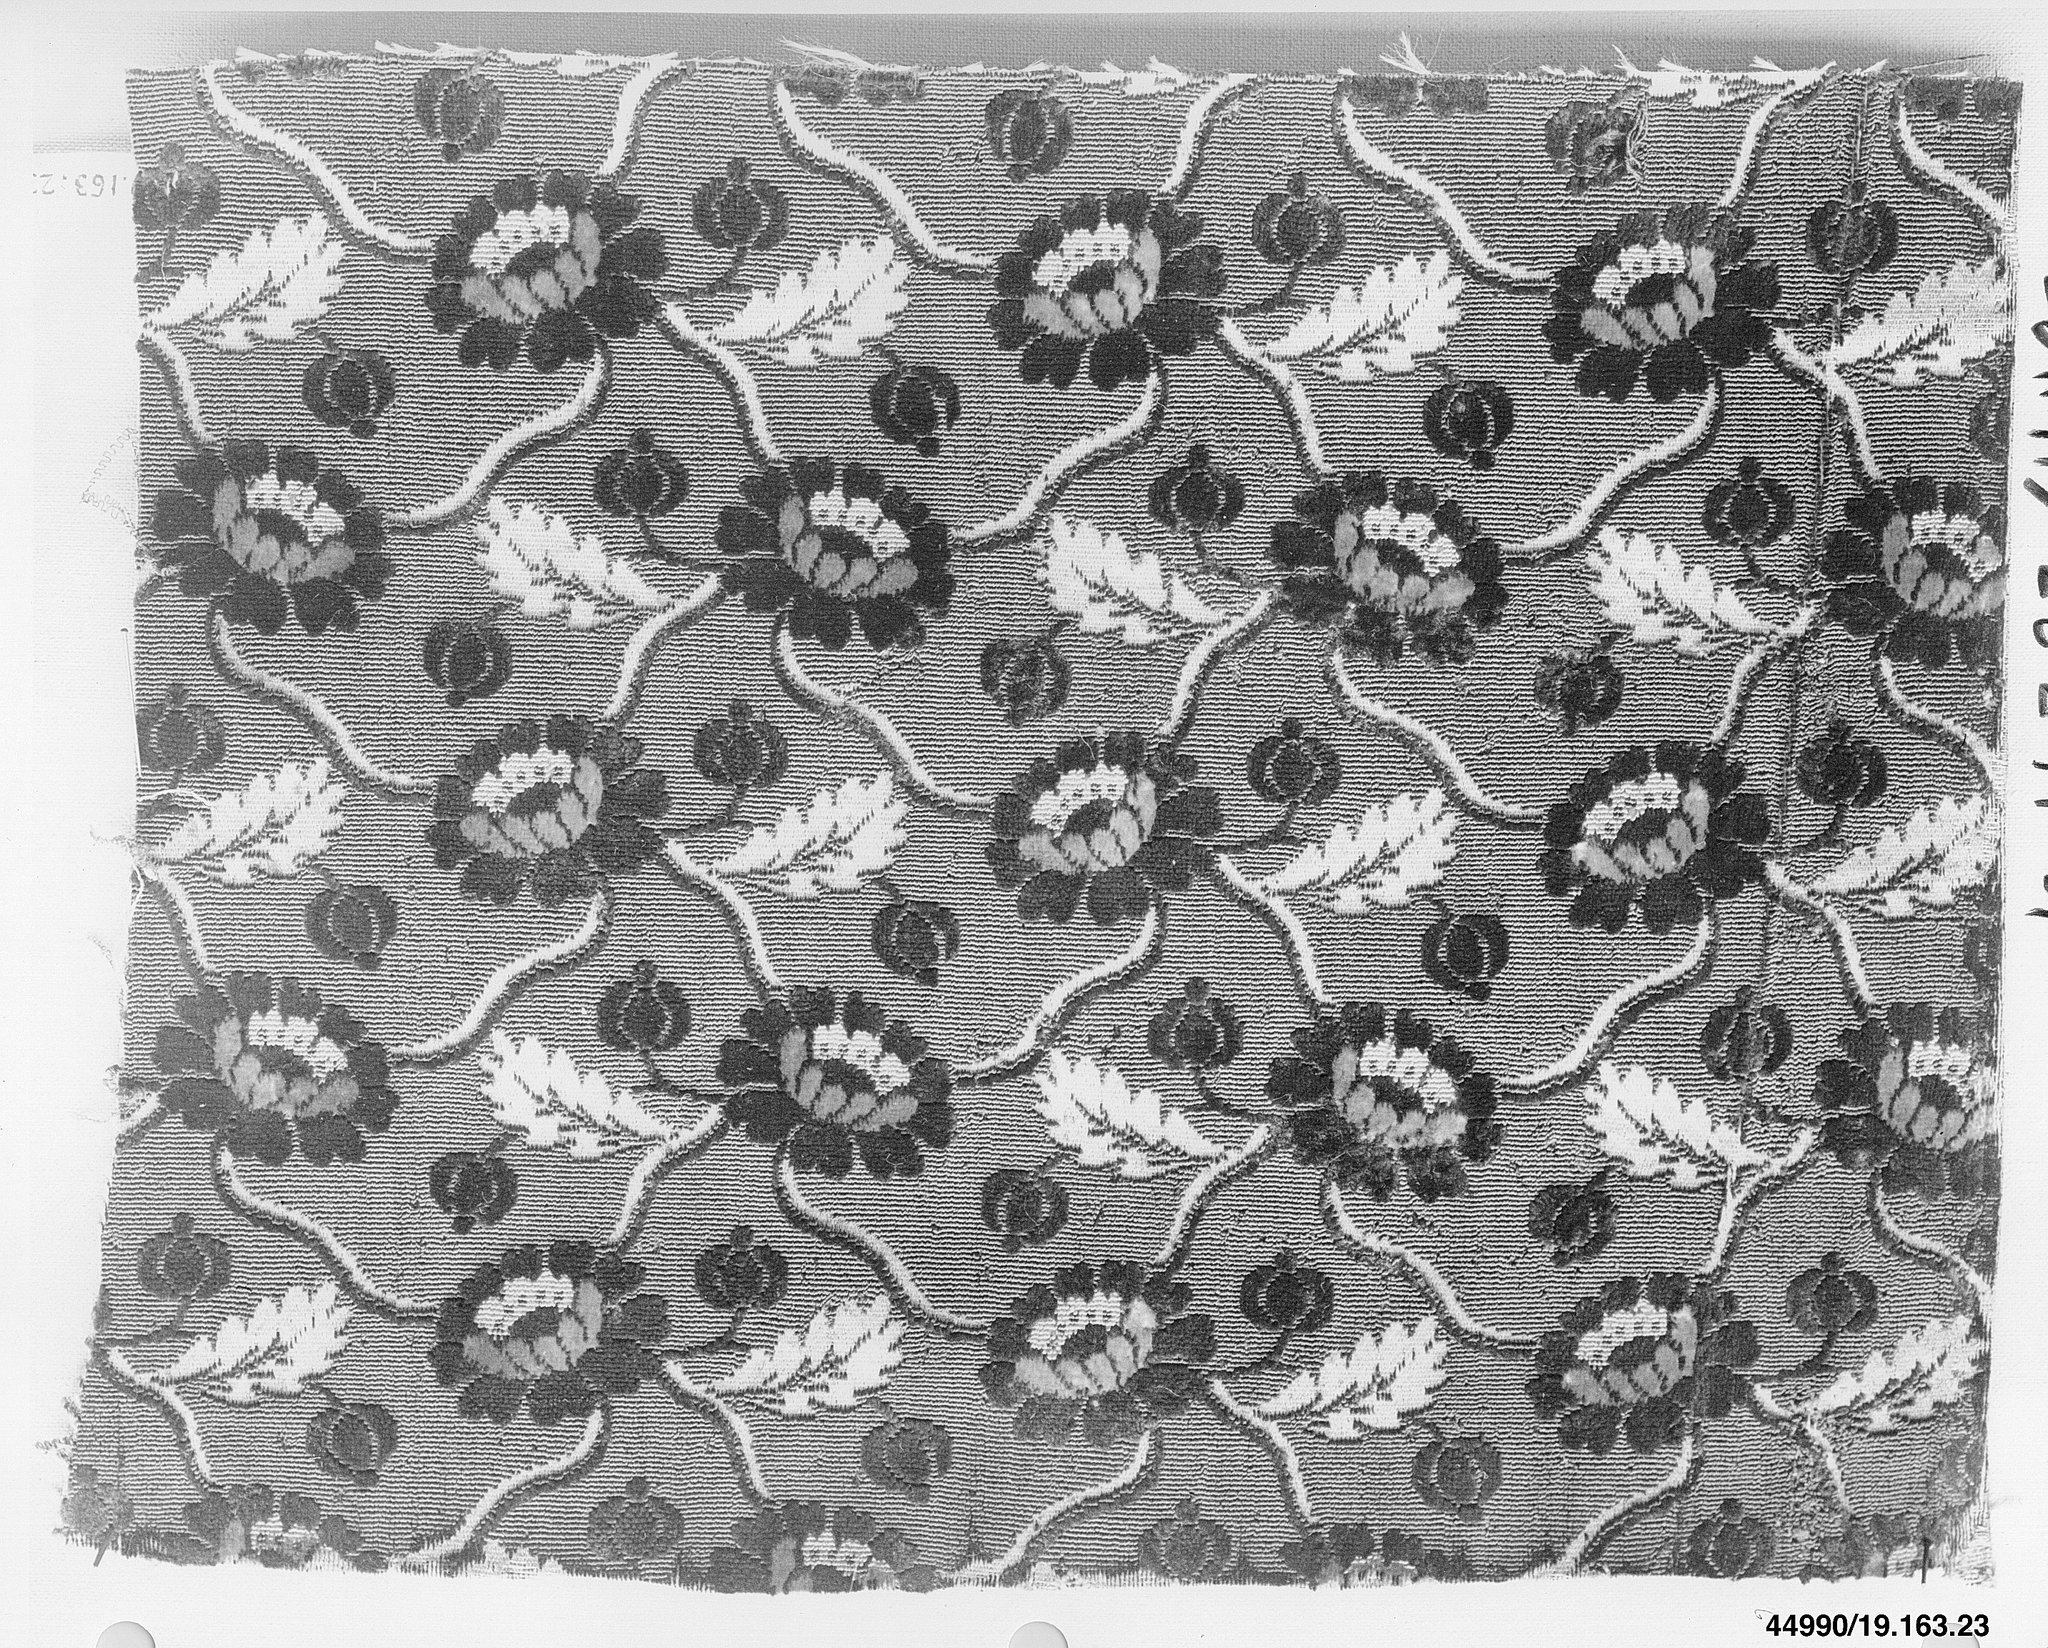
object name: fragment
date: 1750-1775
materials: silk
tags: flowers,leaves